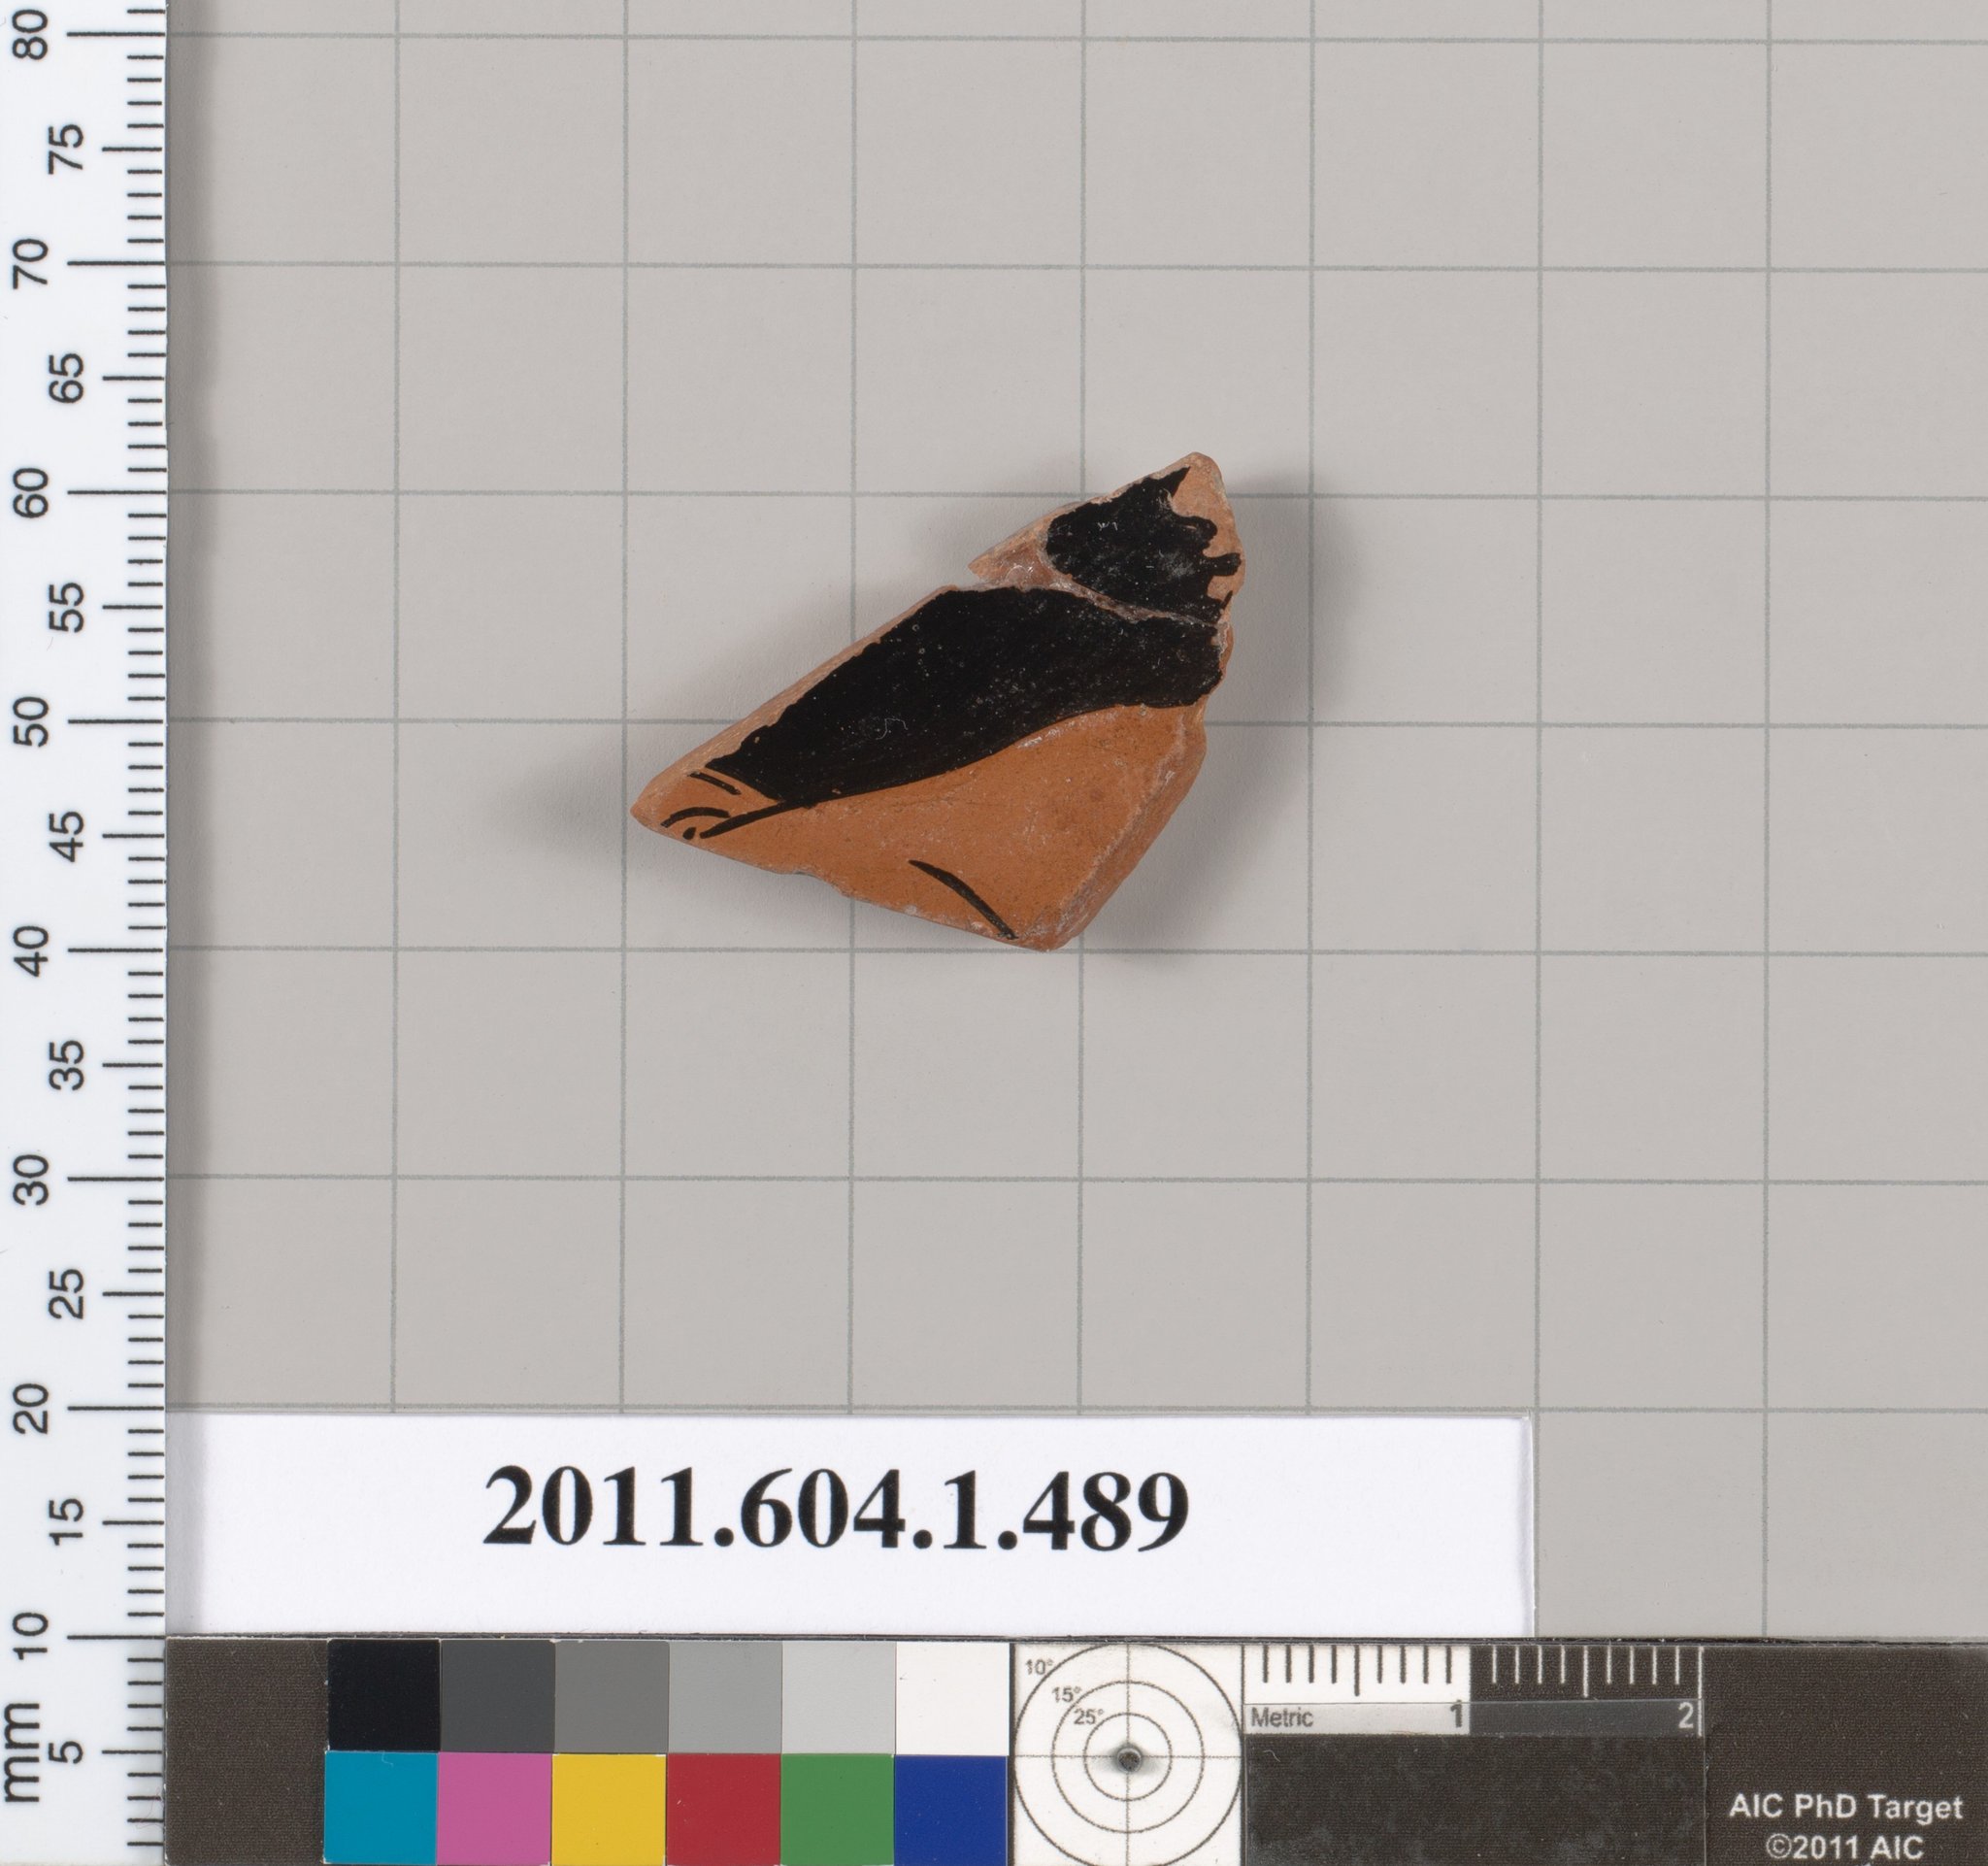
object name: kylix fragment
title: Terracotta fragment of a kylix (drinking cup)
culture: greek, attic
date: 490-480 BCE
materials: terracotta